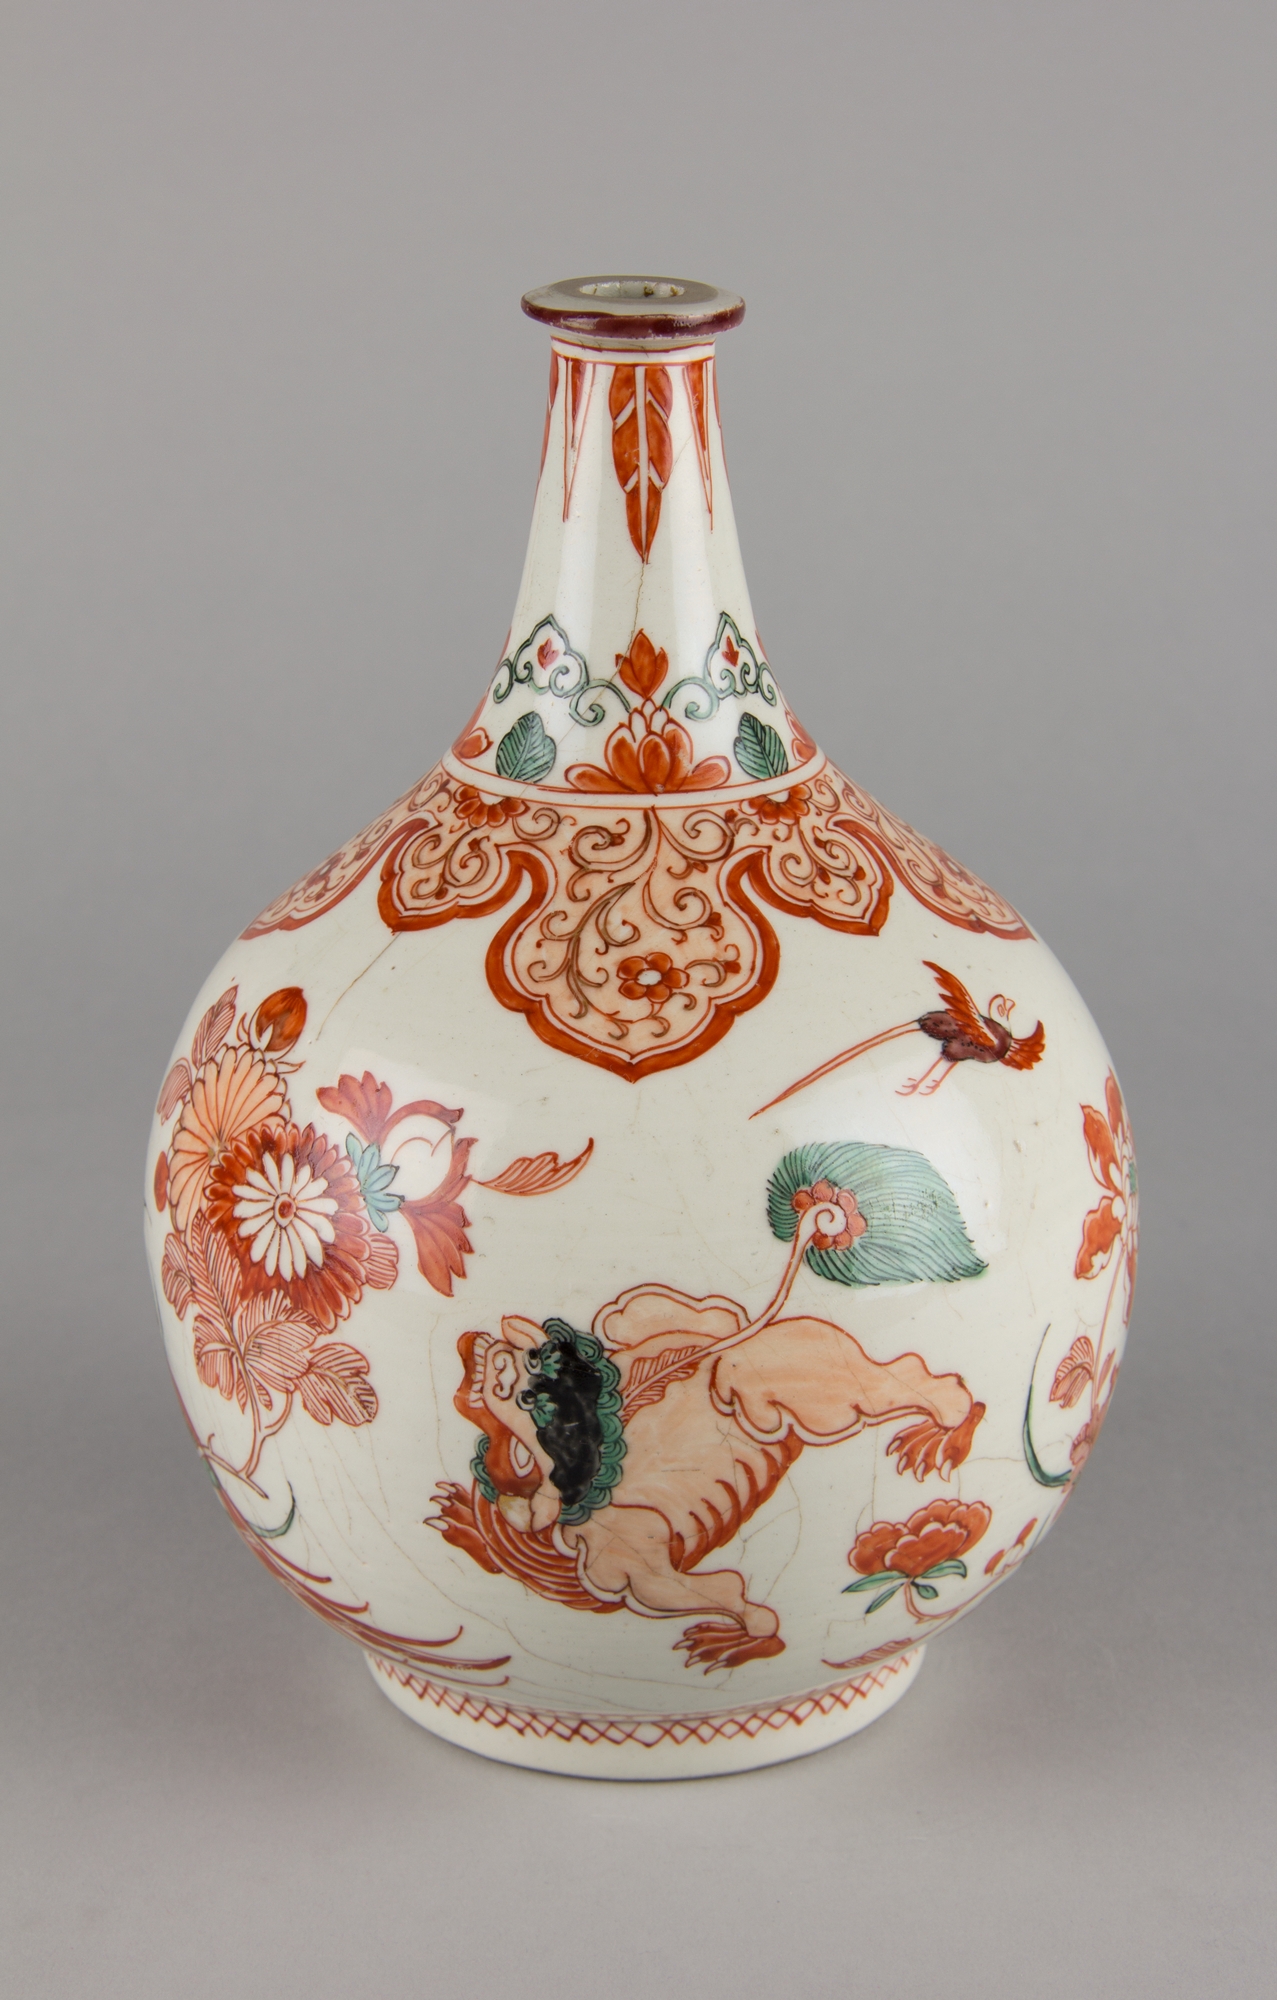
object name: apothecary bottle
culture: japanese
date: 1651-1700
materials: enamel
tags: birds,mythical creatures,flowers